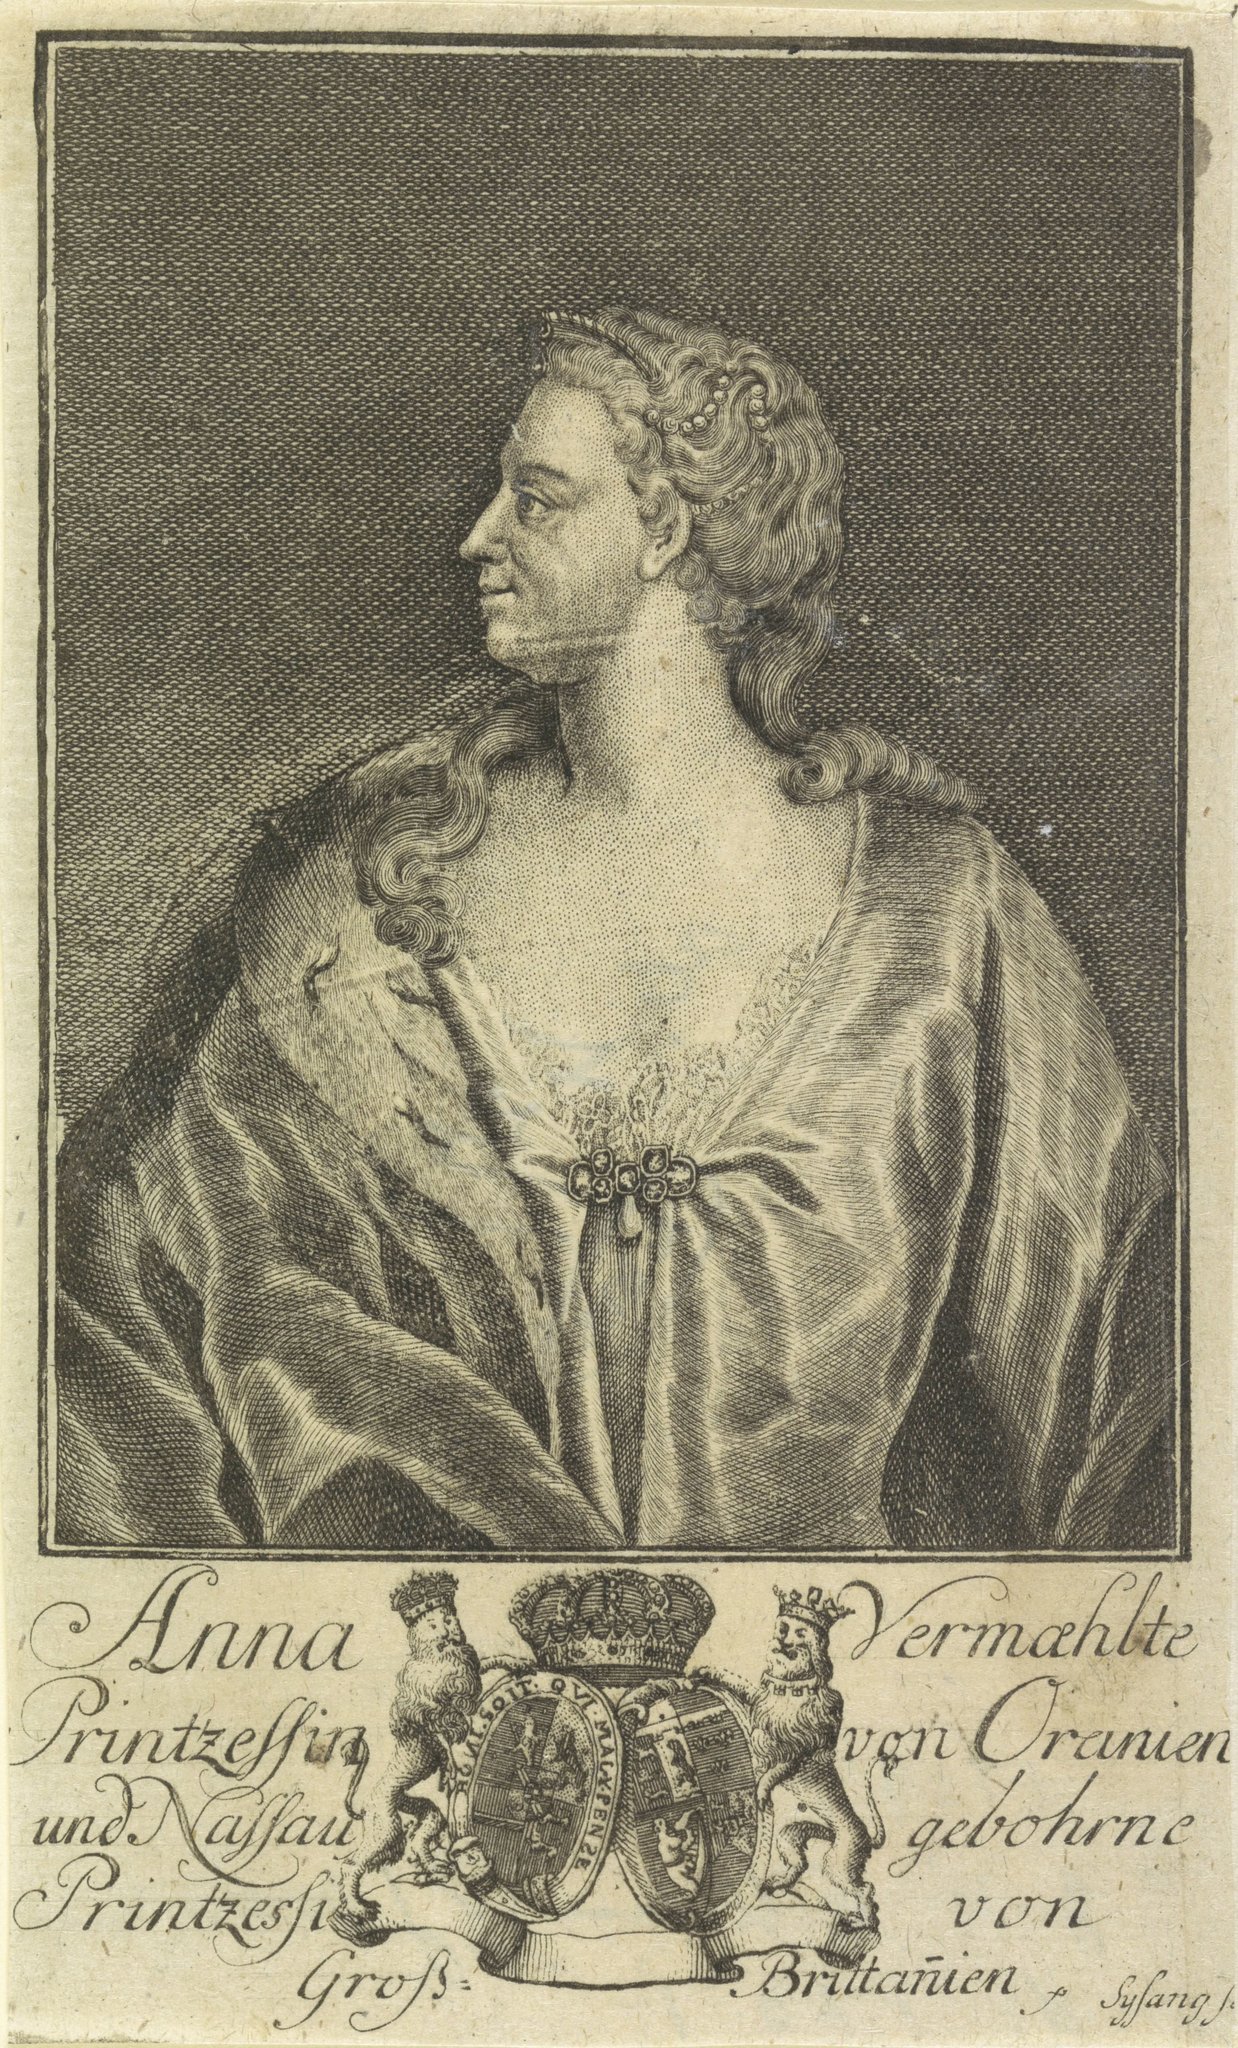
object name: print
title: Portret van Anna van Hannover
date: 1734-1757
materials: paper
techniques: engraving, etching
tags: willem iv (prins van oranje-nassau), the hague, anna van hannover, knighthood order (garter) - insignia of a knighthood order, e.g.: badge, chain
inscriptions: collector's mark: Lugt 2228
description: Portret van Anna. Midden onder haar wapen en het wapen van Willem IV, gedecoreerd met de Kousenband en het devies van de Orde van de Kousenband, met een kroon en twee leeuwen. In de ondermarge haar naam en titels.